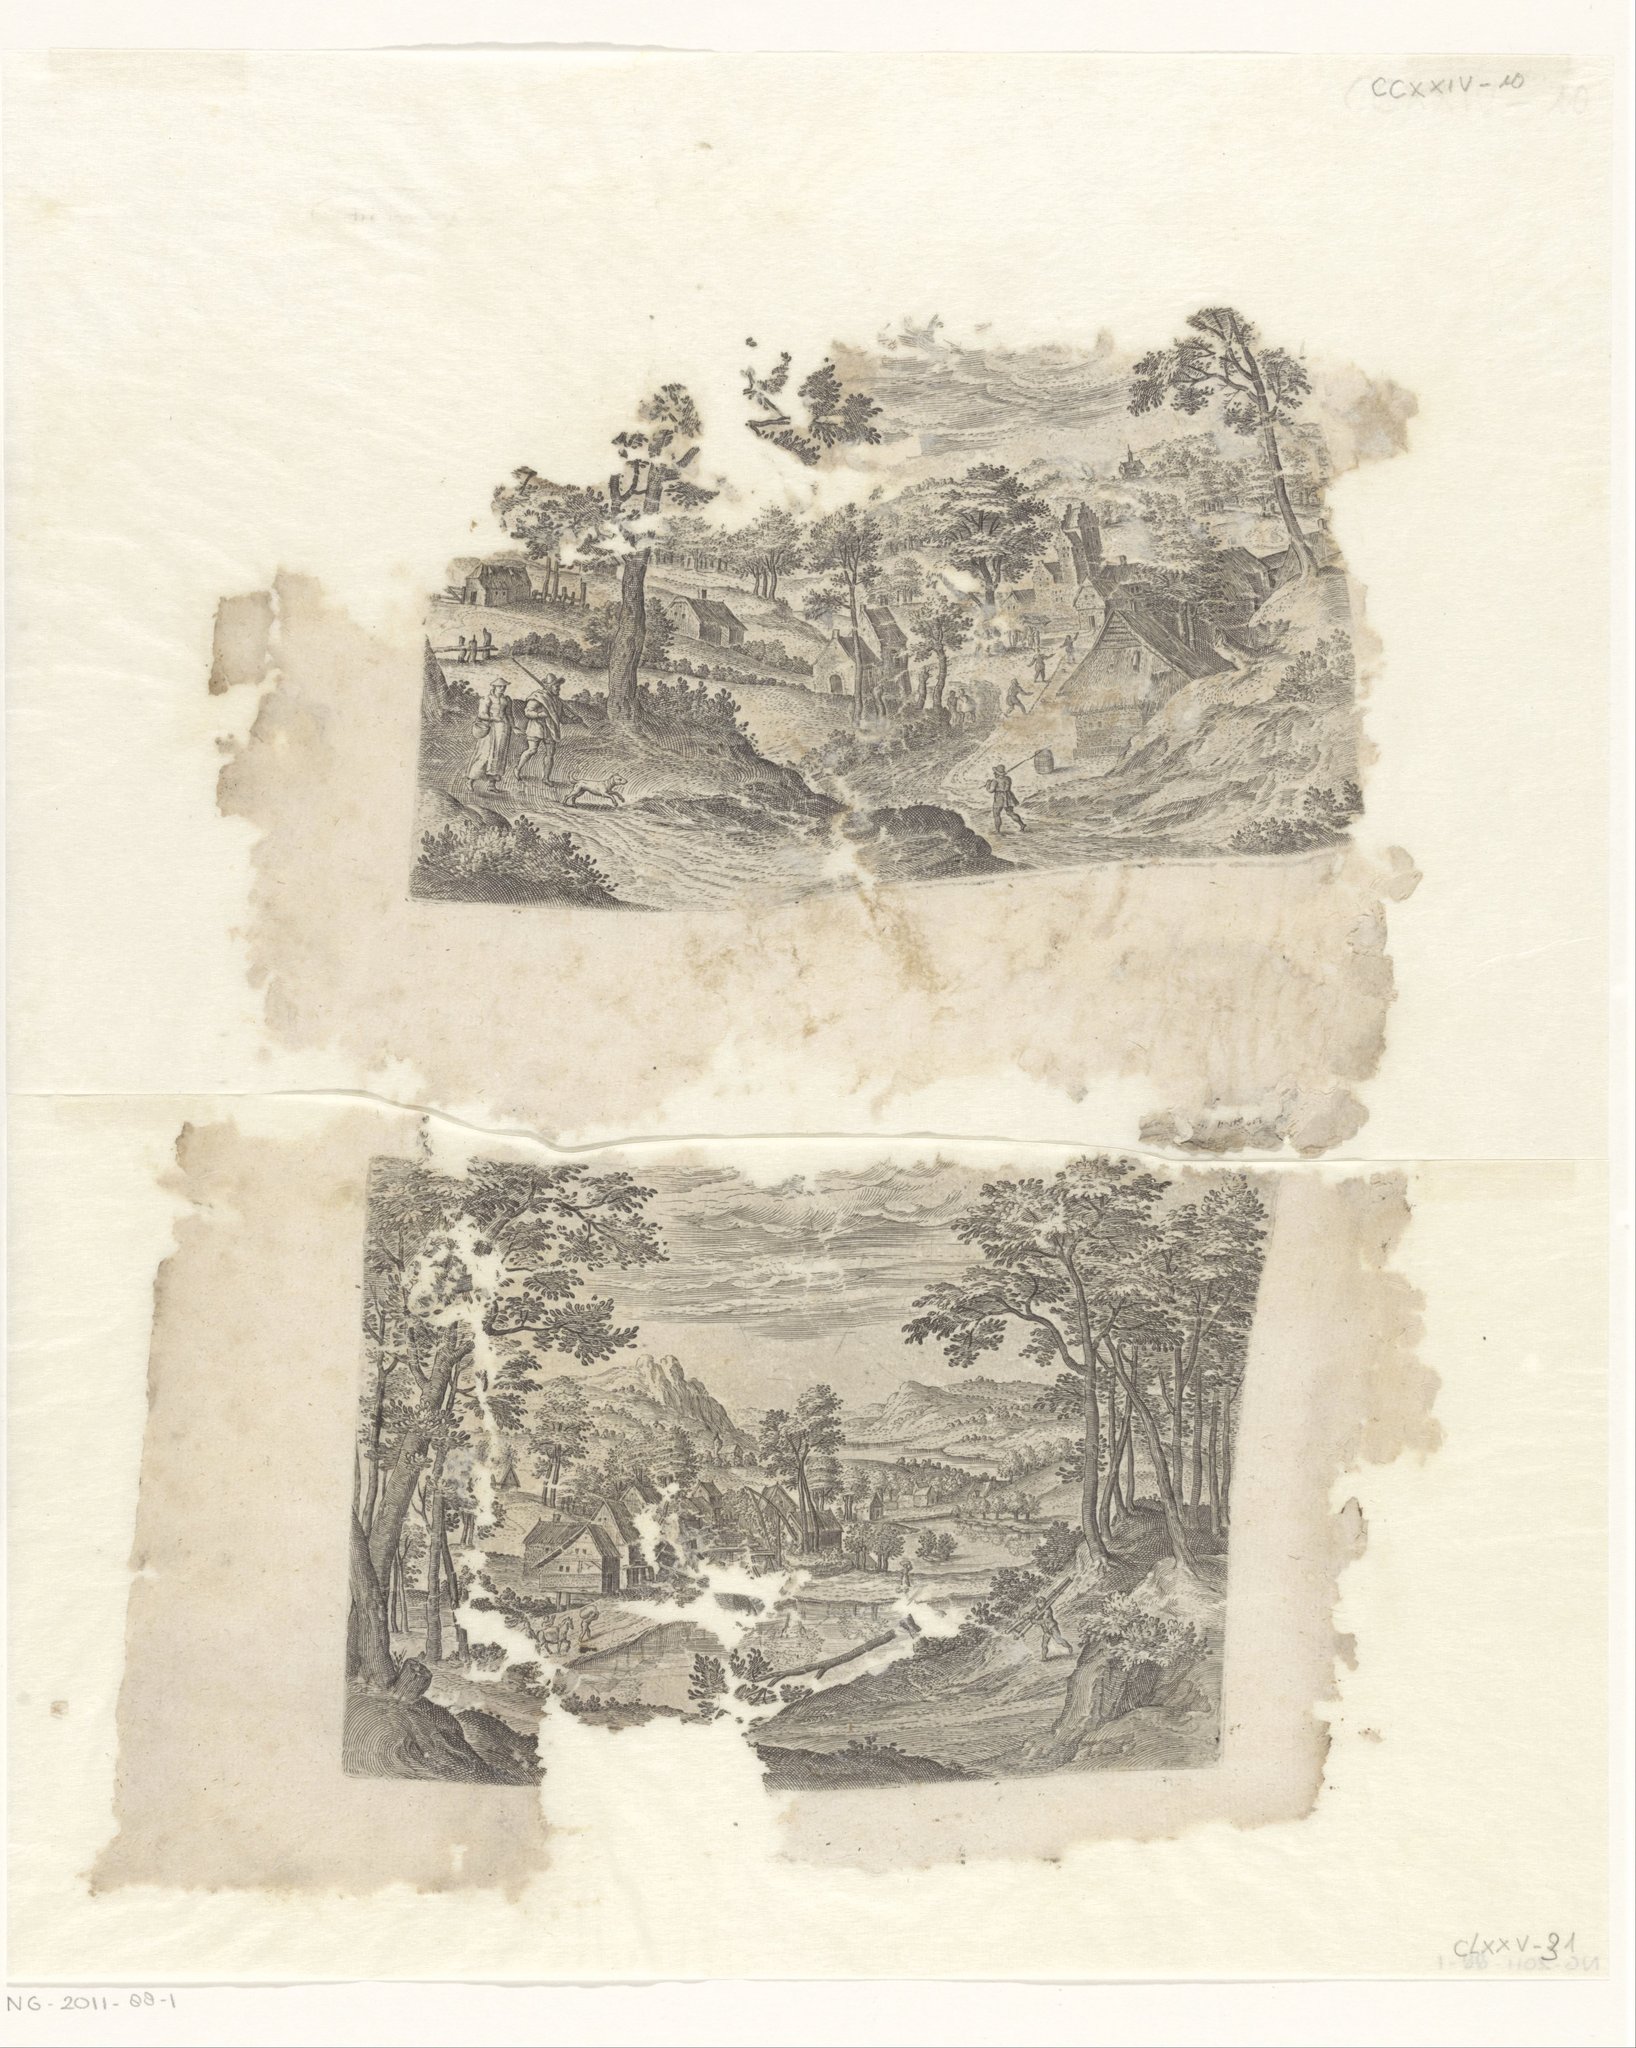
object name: print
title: Sint Iobs te Carolo / Hooch bootffoort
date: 1575-1580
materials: paper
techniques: engraving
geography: southern netherlands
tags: city-view, and landscape with man-made constructions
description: Prenten zijn onderdeel van een serie van 24. De prenten in de Nova Zembla collectie zijn tijdens een expeditie van Willem Barendsz en Jacob van Heemskerk in 1596-1597 noodgedwongen in het winterkamp, het ‘Behouden Huis’, op het eiland achtergelaten. De prenten waren in één of meerdere stapels als handelswaar meegenomen vanuit Amsterdam. Bijna drie eeuwen later, in 1871, keerde de Noor Elling Carlsen terug naar Nova Zembla en vond daar de restanten van het ‘Behouden Huis, inclusief een groot deel van de inventaris. Een deel van de prenten, in de vorm van aaneengekoekte kluiten, werd toen ook teruggevonden. De papierkluiten waren soms op meerdere plekken gebroken. Tussen 1975-1979 zijn de prenten van elkaar gescheiden. Dit leverde in totaal ca. 1000 fragmenten van ca. 400 afdrukken van ca. 150 verschillende prenten op. Voor zover mogelijk zijn de fragmenten samengevoegd en zijn de prenten gereconstrueerd.